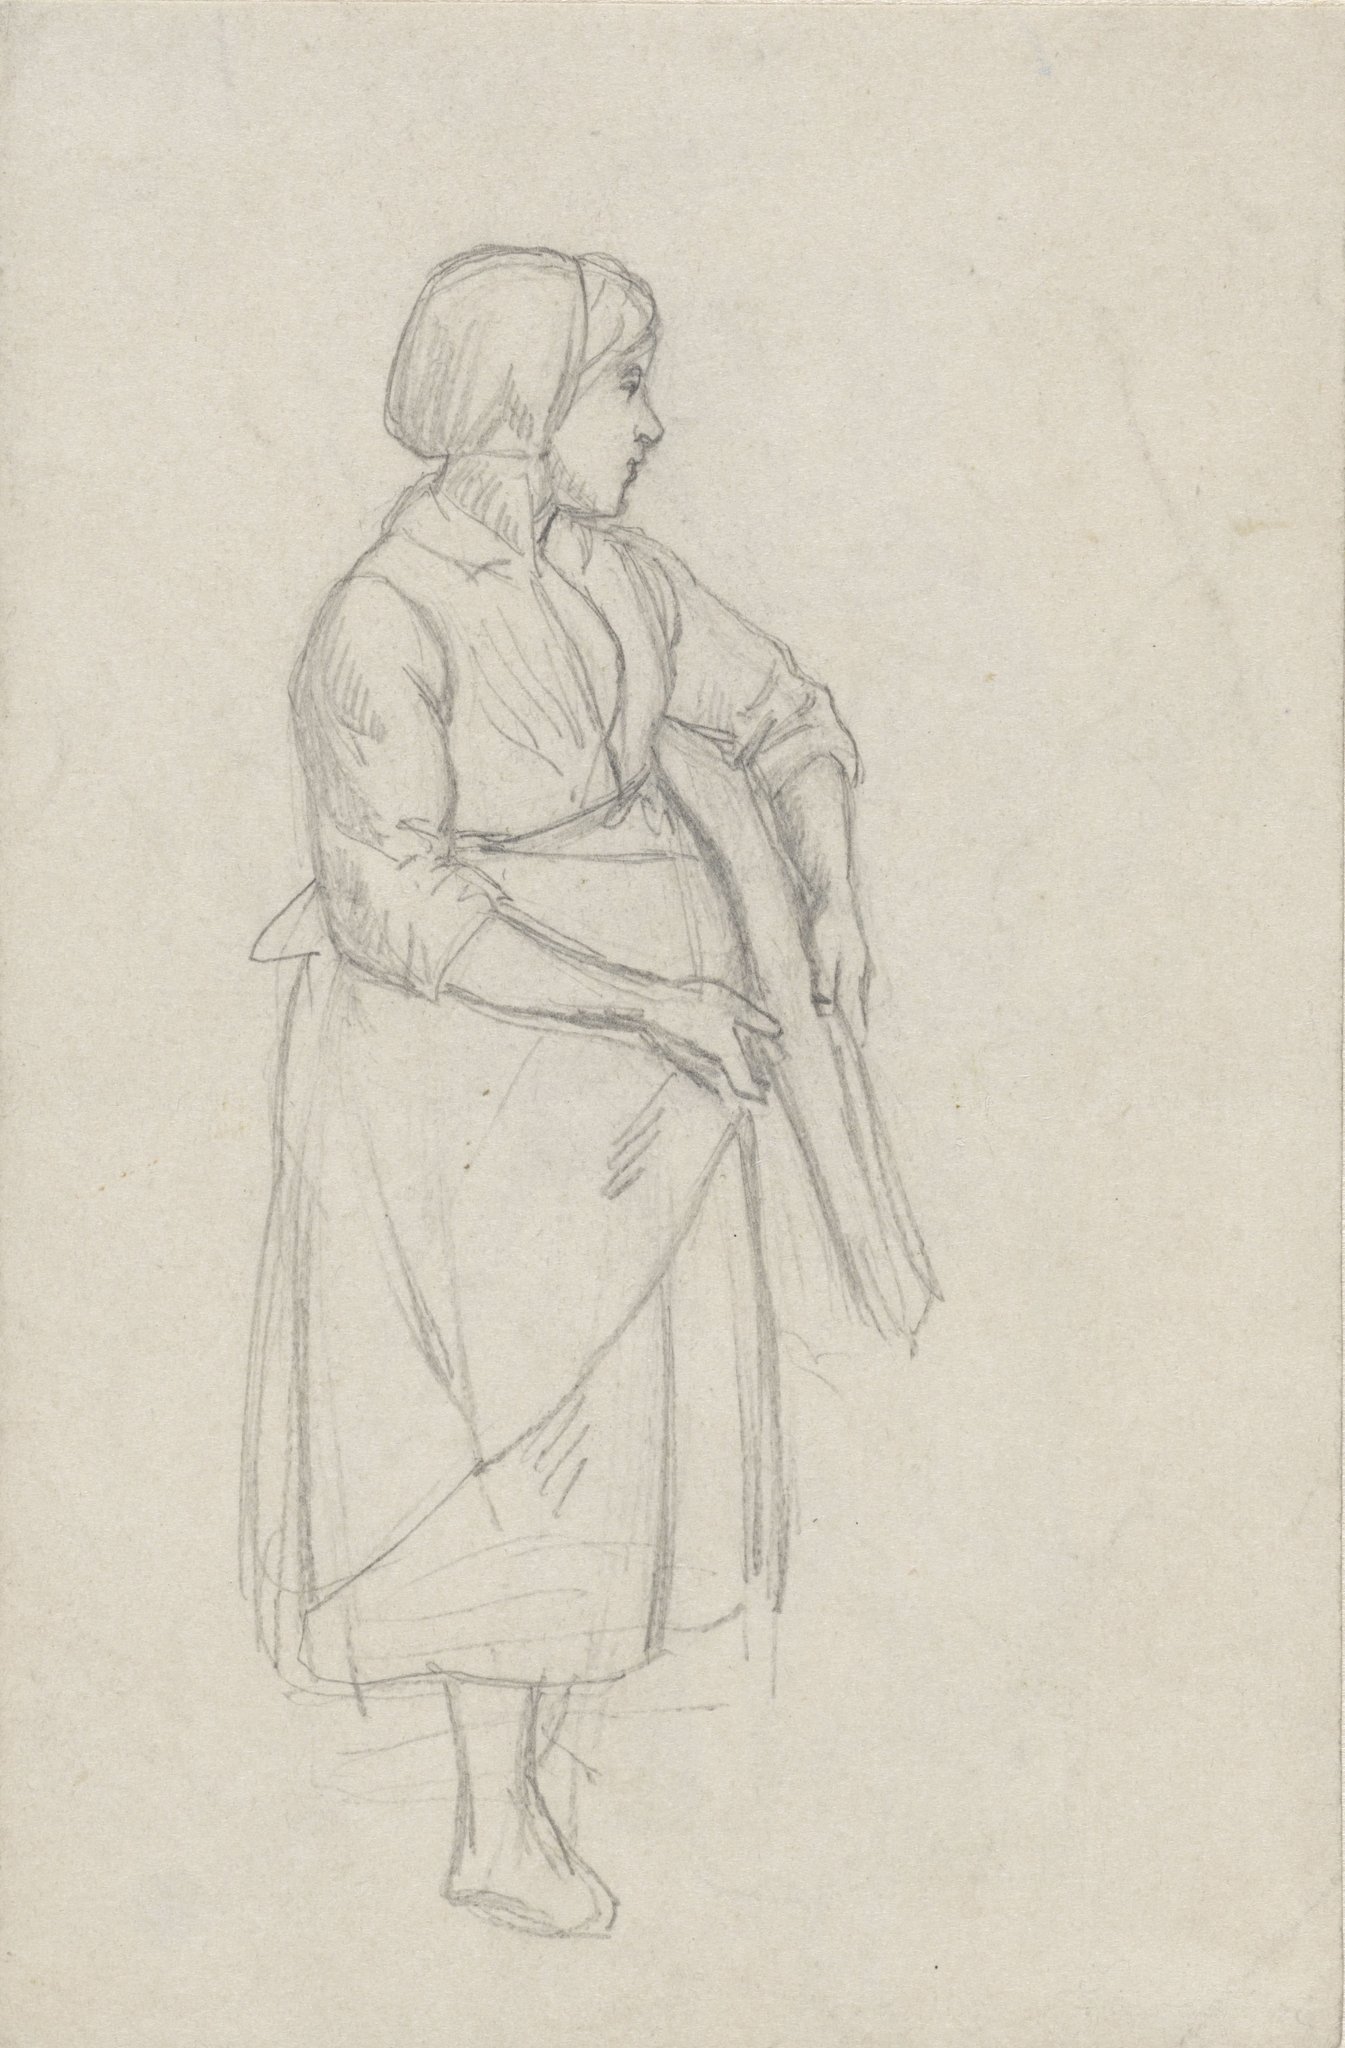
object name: drawing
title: Schets van een meisje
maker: philip sadée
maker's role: draughtsman, painter, print maker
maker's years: 1837-1904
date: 1847-1904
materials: paper, pencil